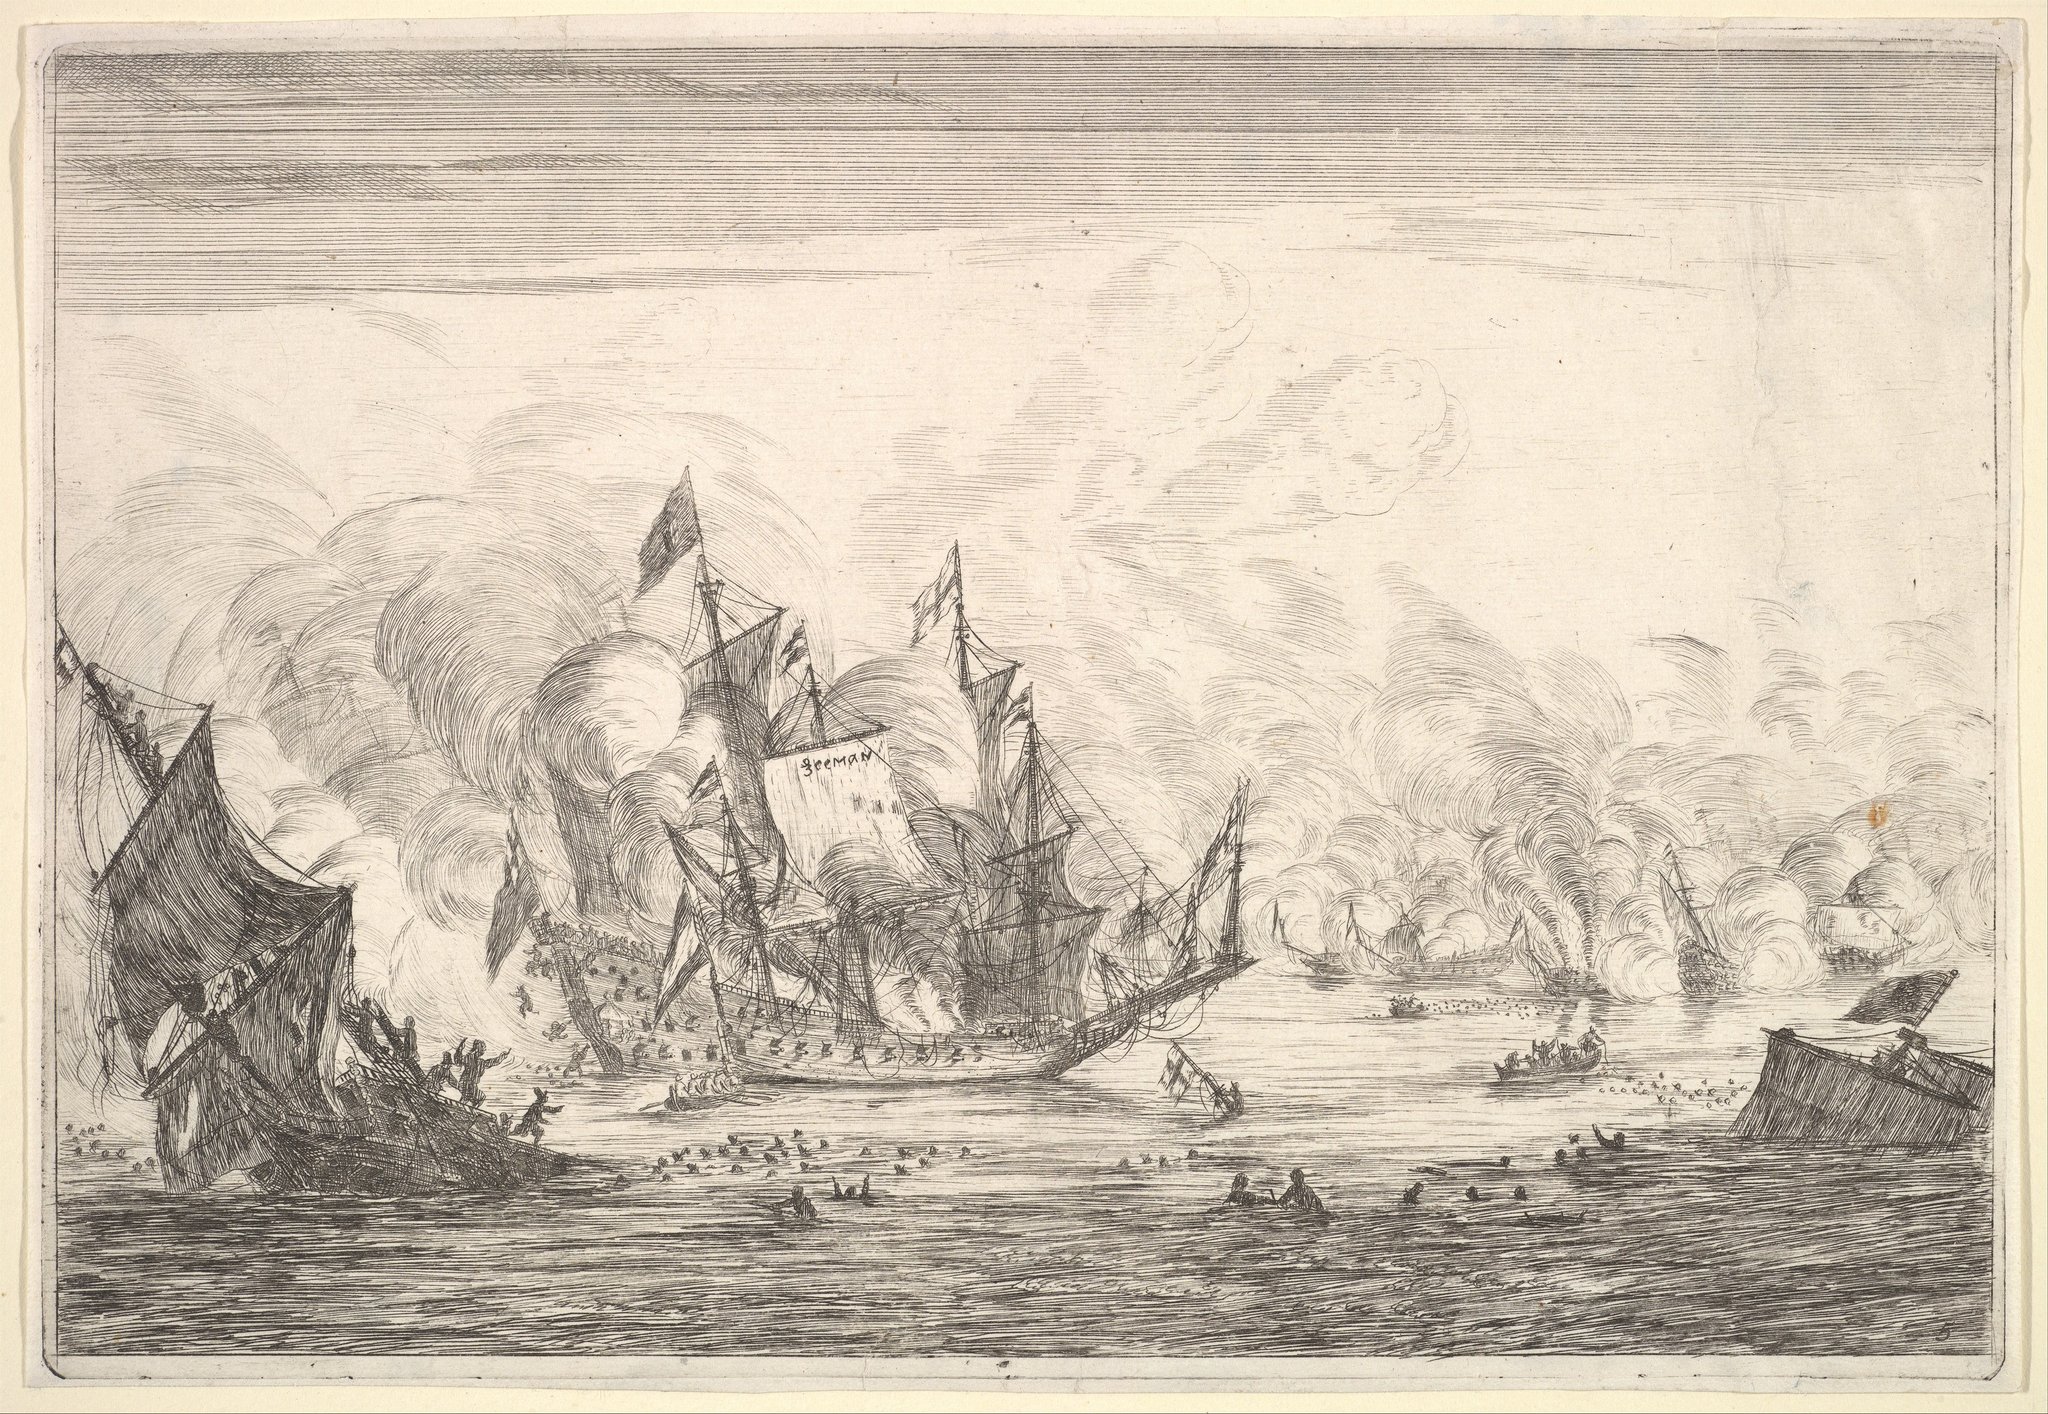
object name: print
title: Naval Battle with an English Ship Foundering on the Left, from Naval Battles (Nieuwe Scheeps Batalien), plate 5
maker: reinier nooms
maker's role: artist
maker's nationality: dutch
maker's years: 1623-1664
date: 1652-1654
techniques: etching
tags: battles,navy,ships